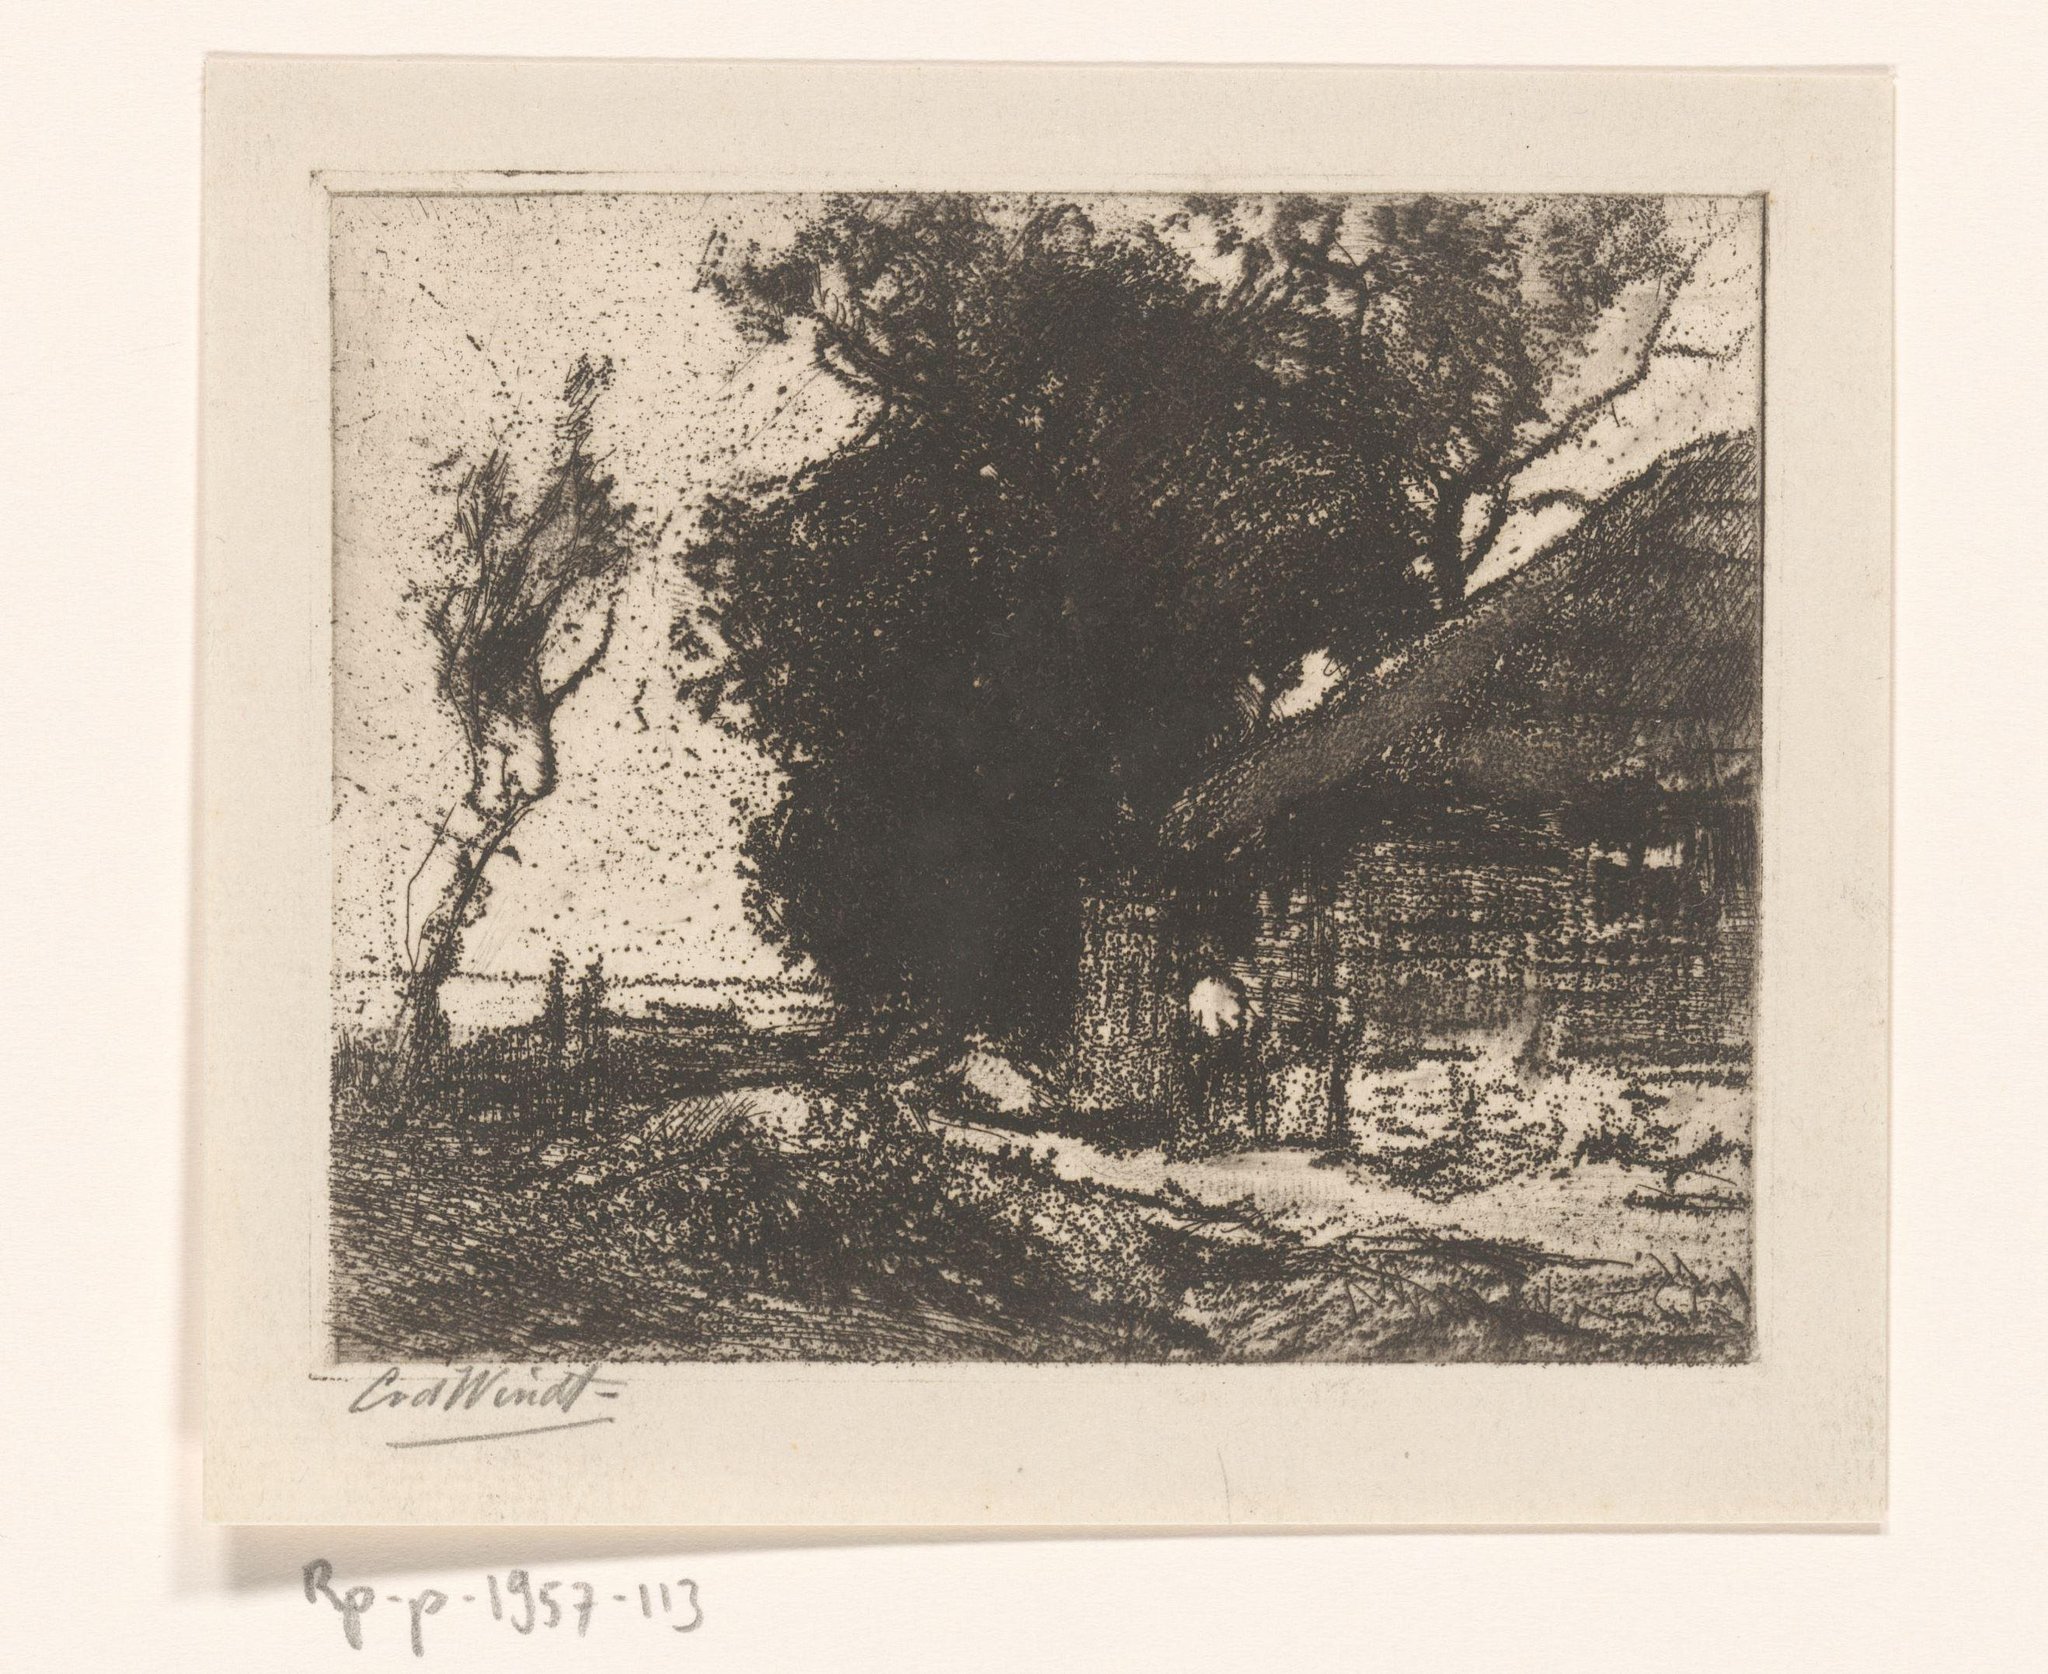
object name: print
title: Bomen bij een boerderij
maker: chris van der windt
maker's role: print maker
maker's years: 1877-1952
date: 1887-1952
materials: paper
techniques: etching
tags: farm or solitary house in landscape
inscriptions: collector's mark: Lugt 2228